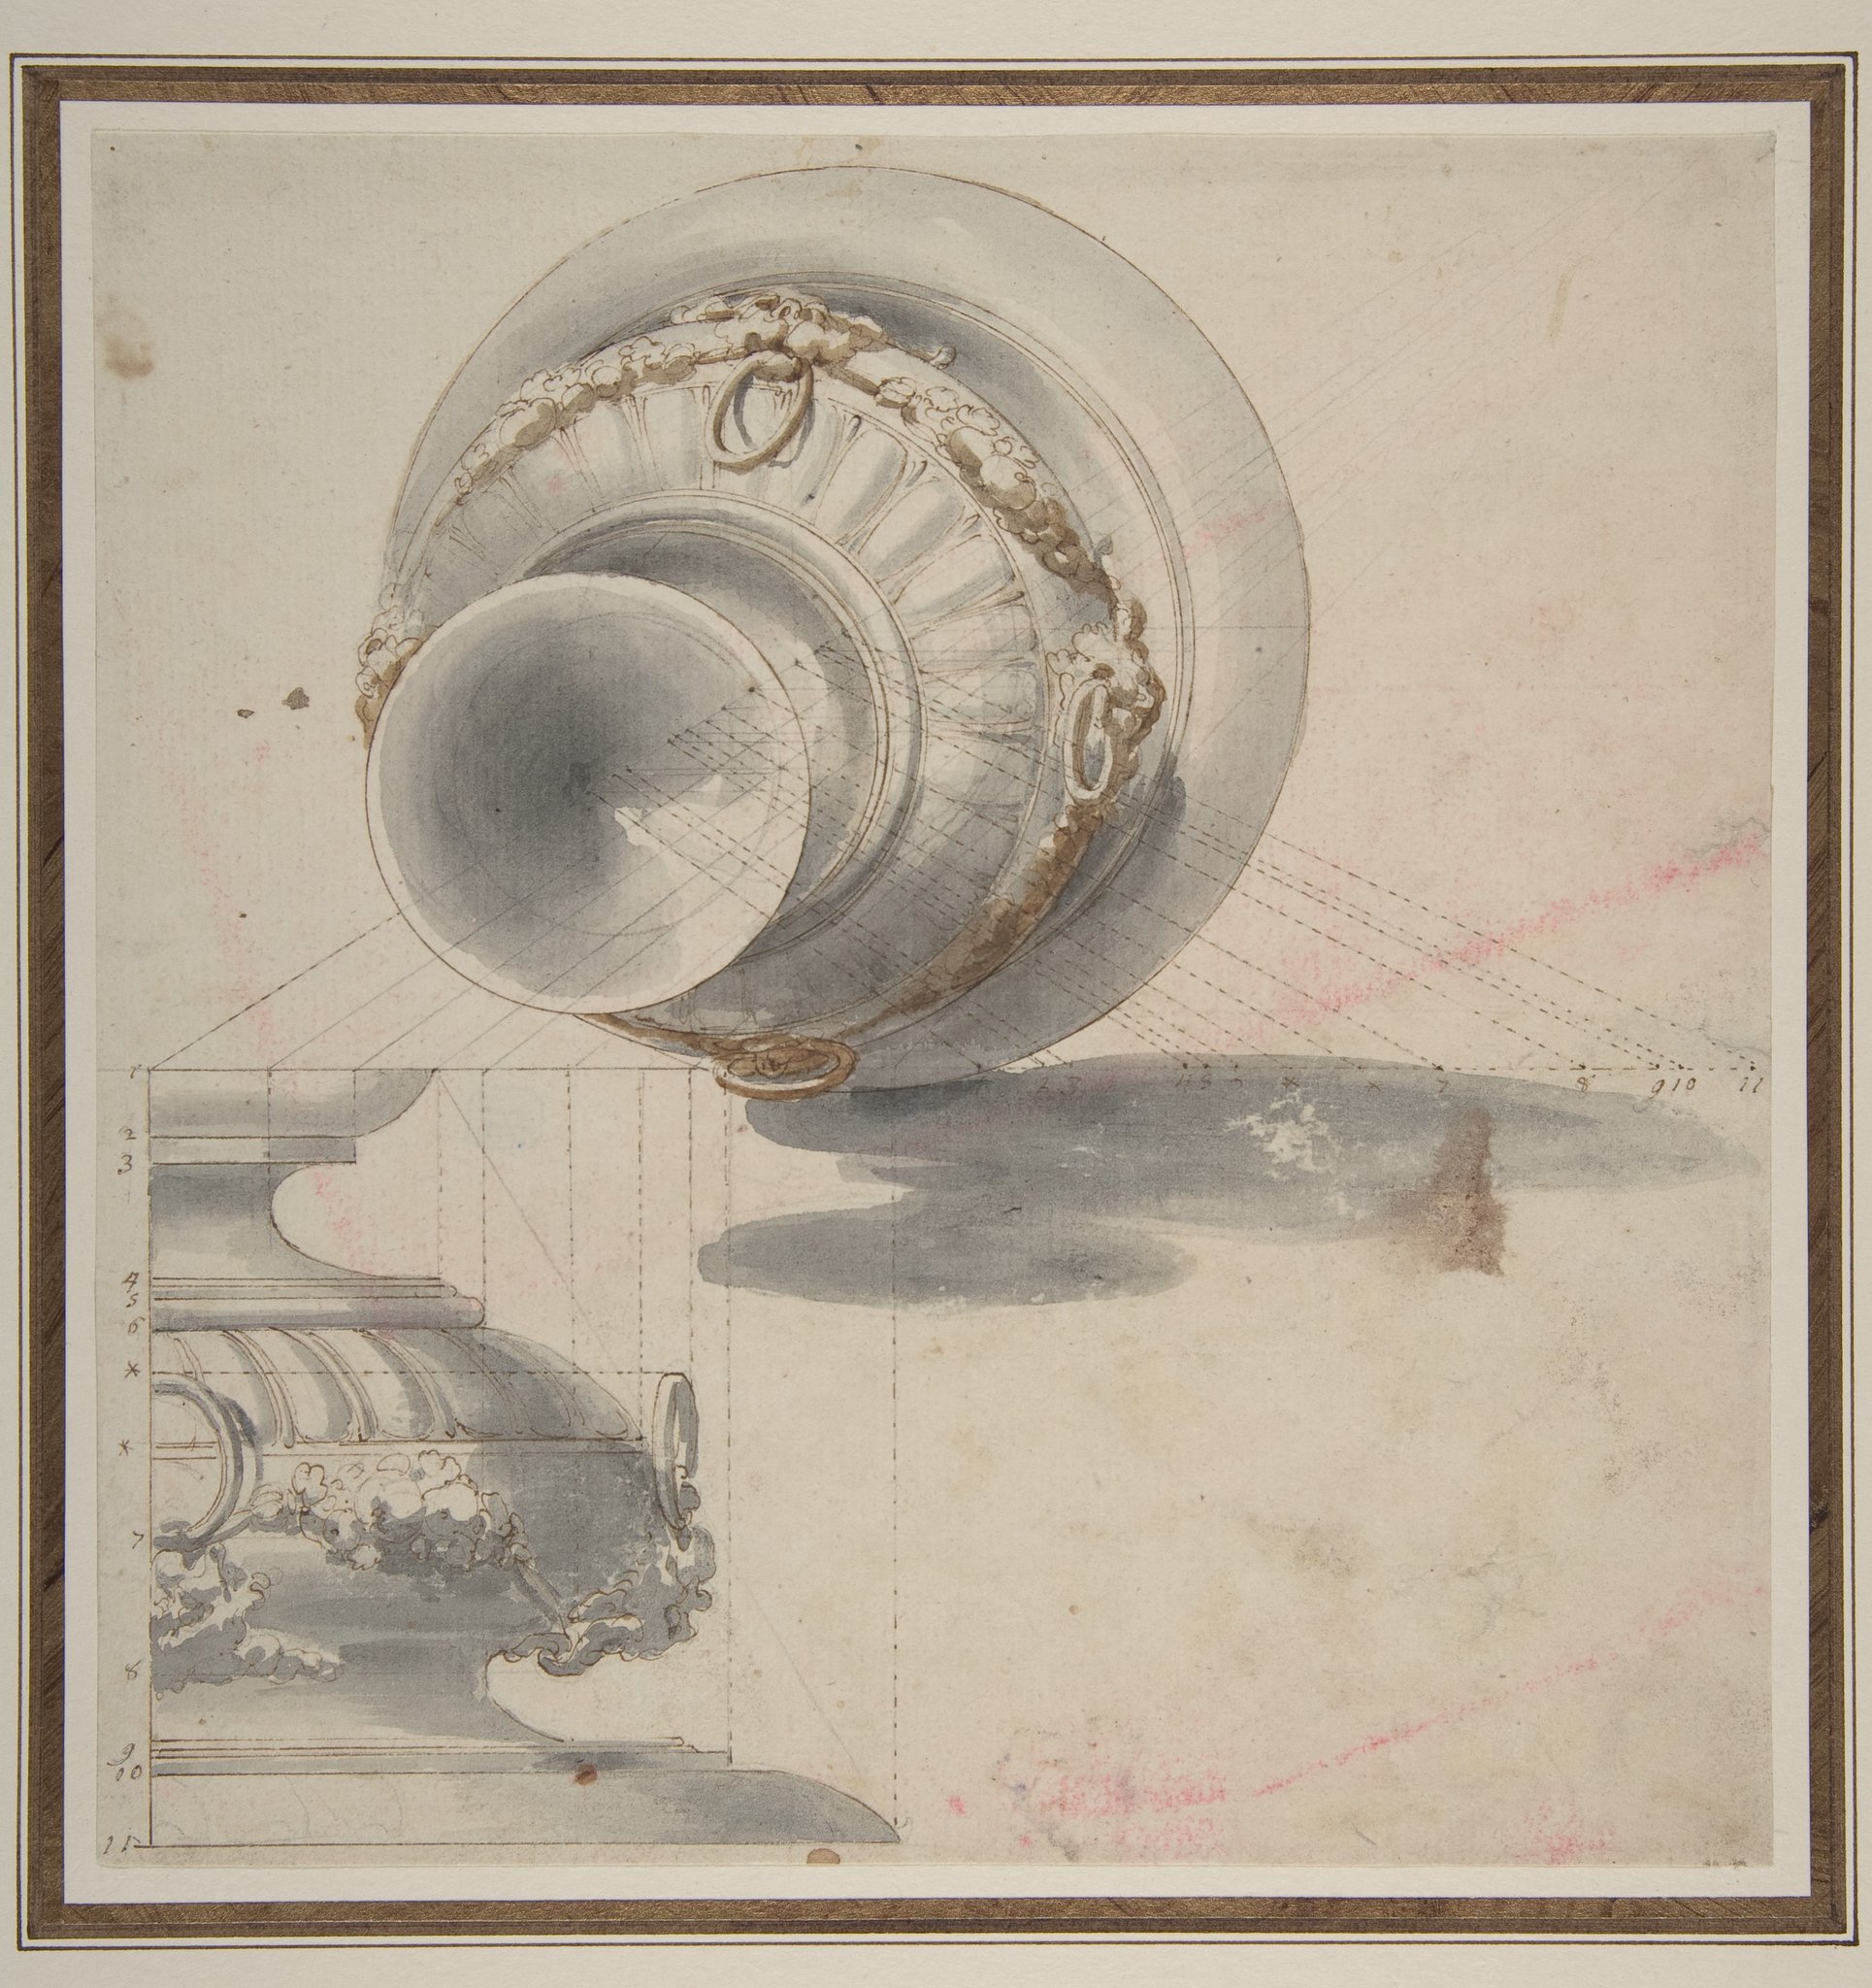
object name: drawing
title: Design of a Perspective projection for an Urn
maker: flaminio innocenzo minozzi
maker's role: artist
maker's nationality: italian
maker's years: 1735-1817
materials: chalk, ink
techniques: brush, pen, wash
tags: urns